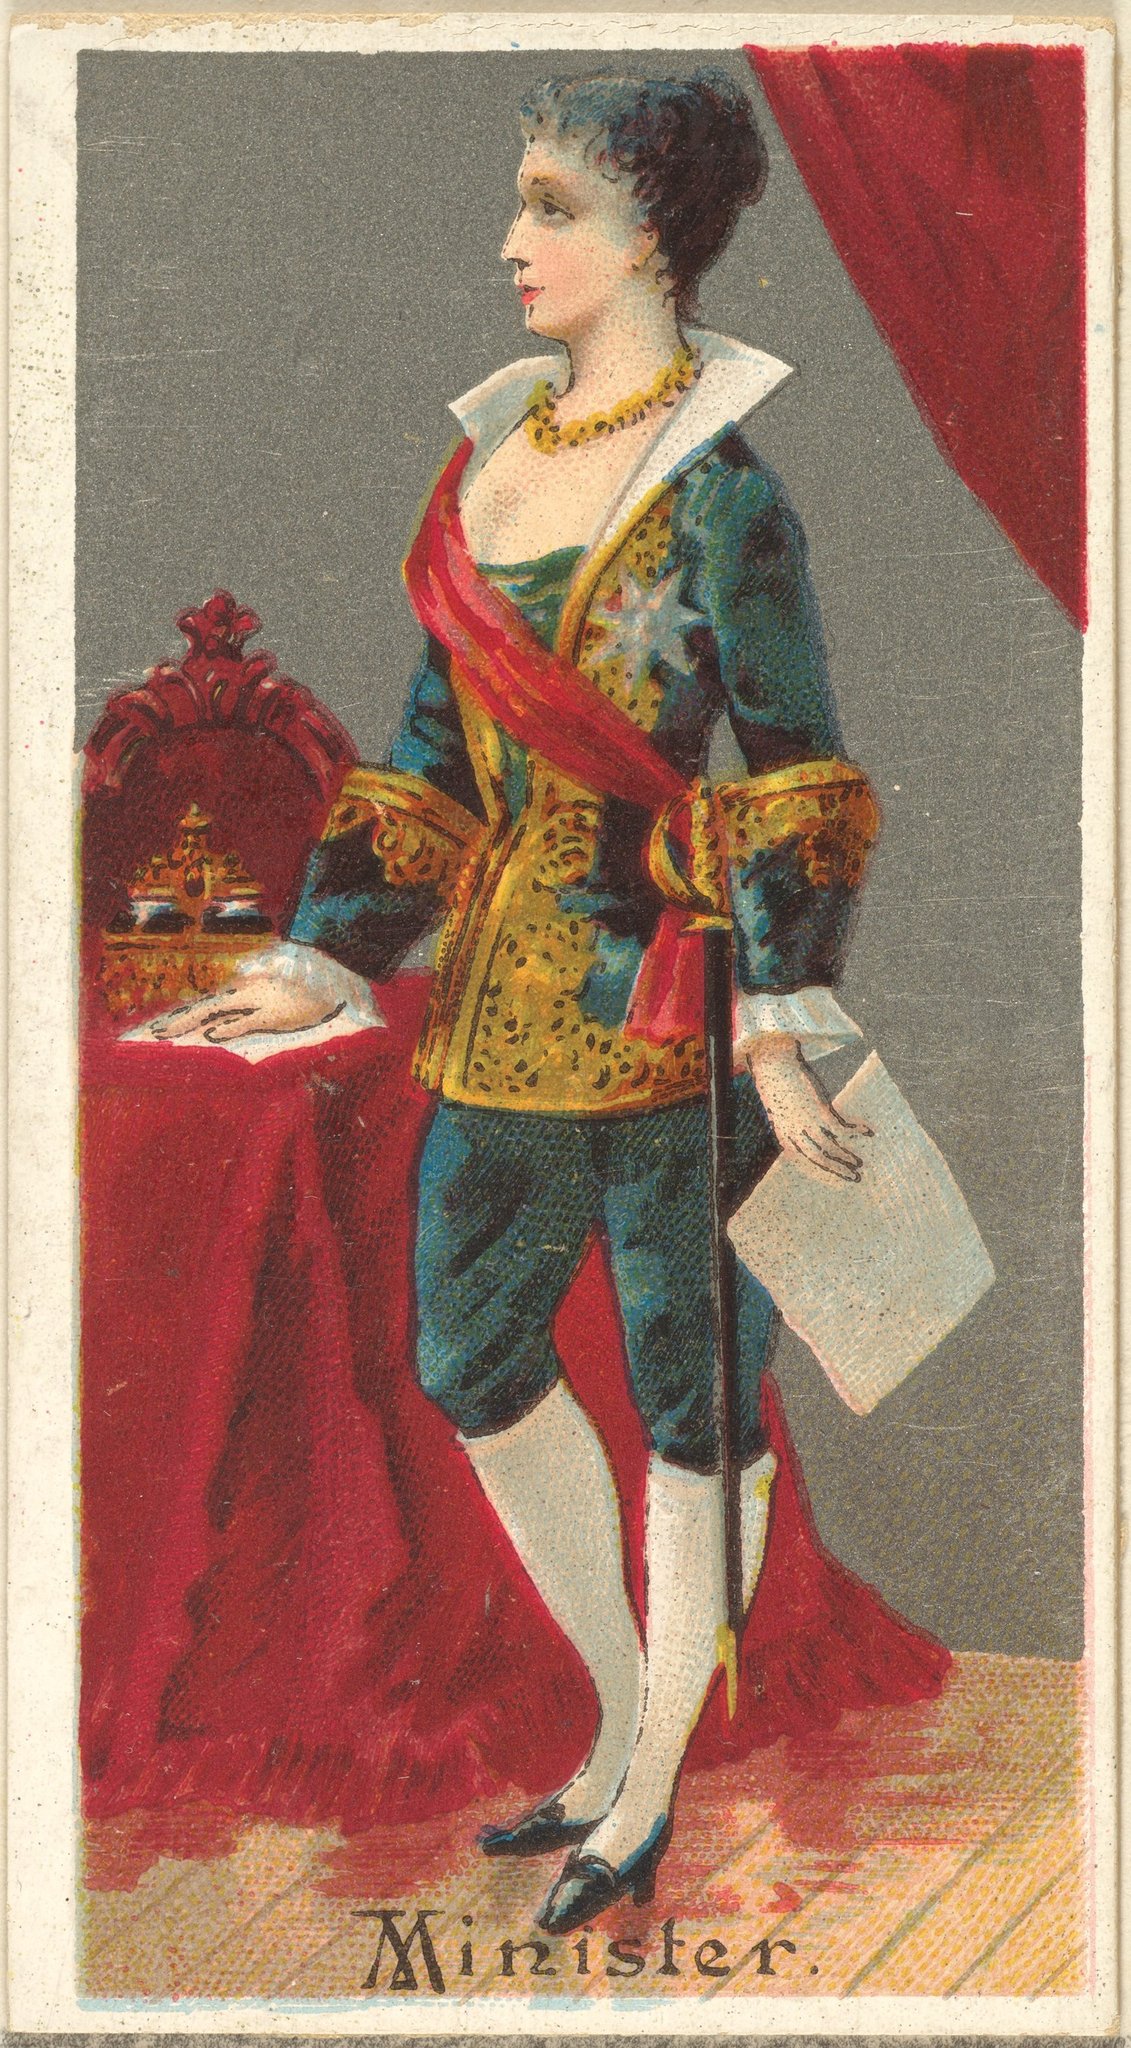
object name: print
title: Minister, from the Occupations for Women series (N166) for Old Judge and Dogs Head Cigarettes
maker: goodwin & company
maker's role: publisher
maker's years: 1850-1950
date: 1887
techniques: color lithograph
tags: profiles,women